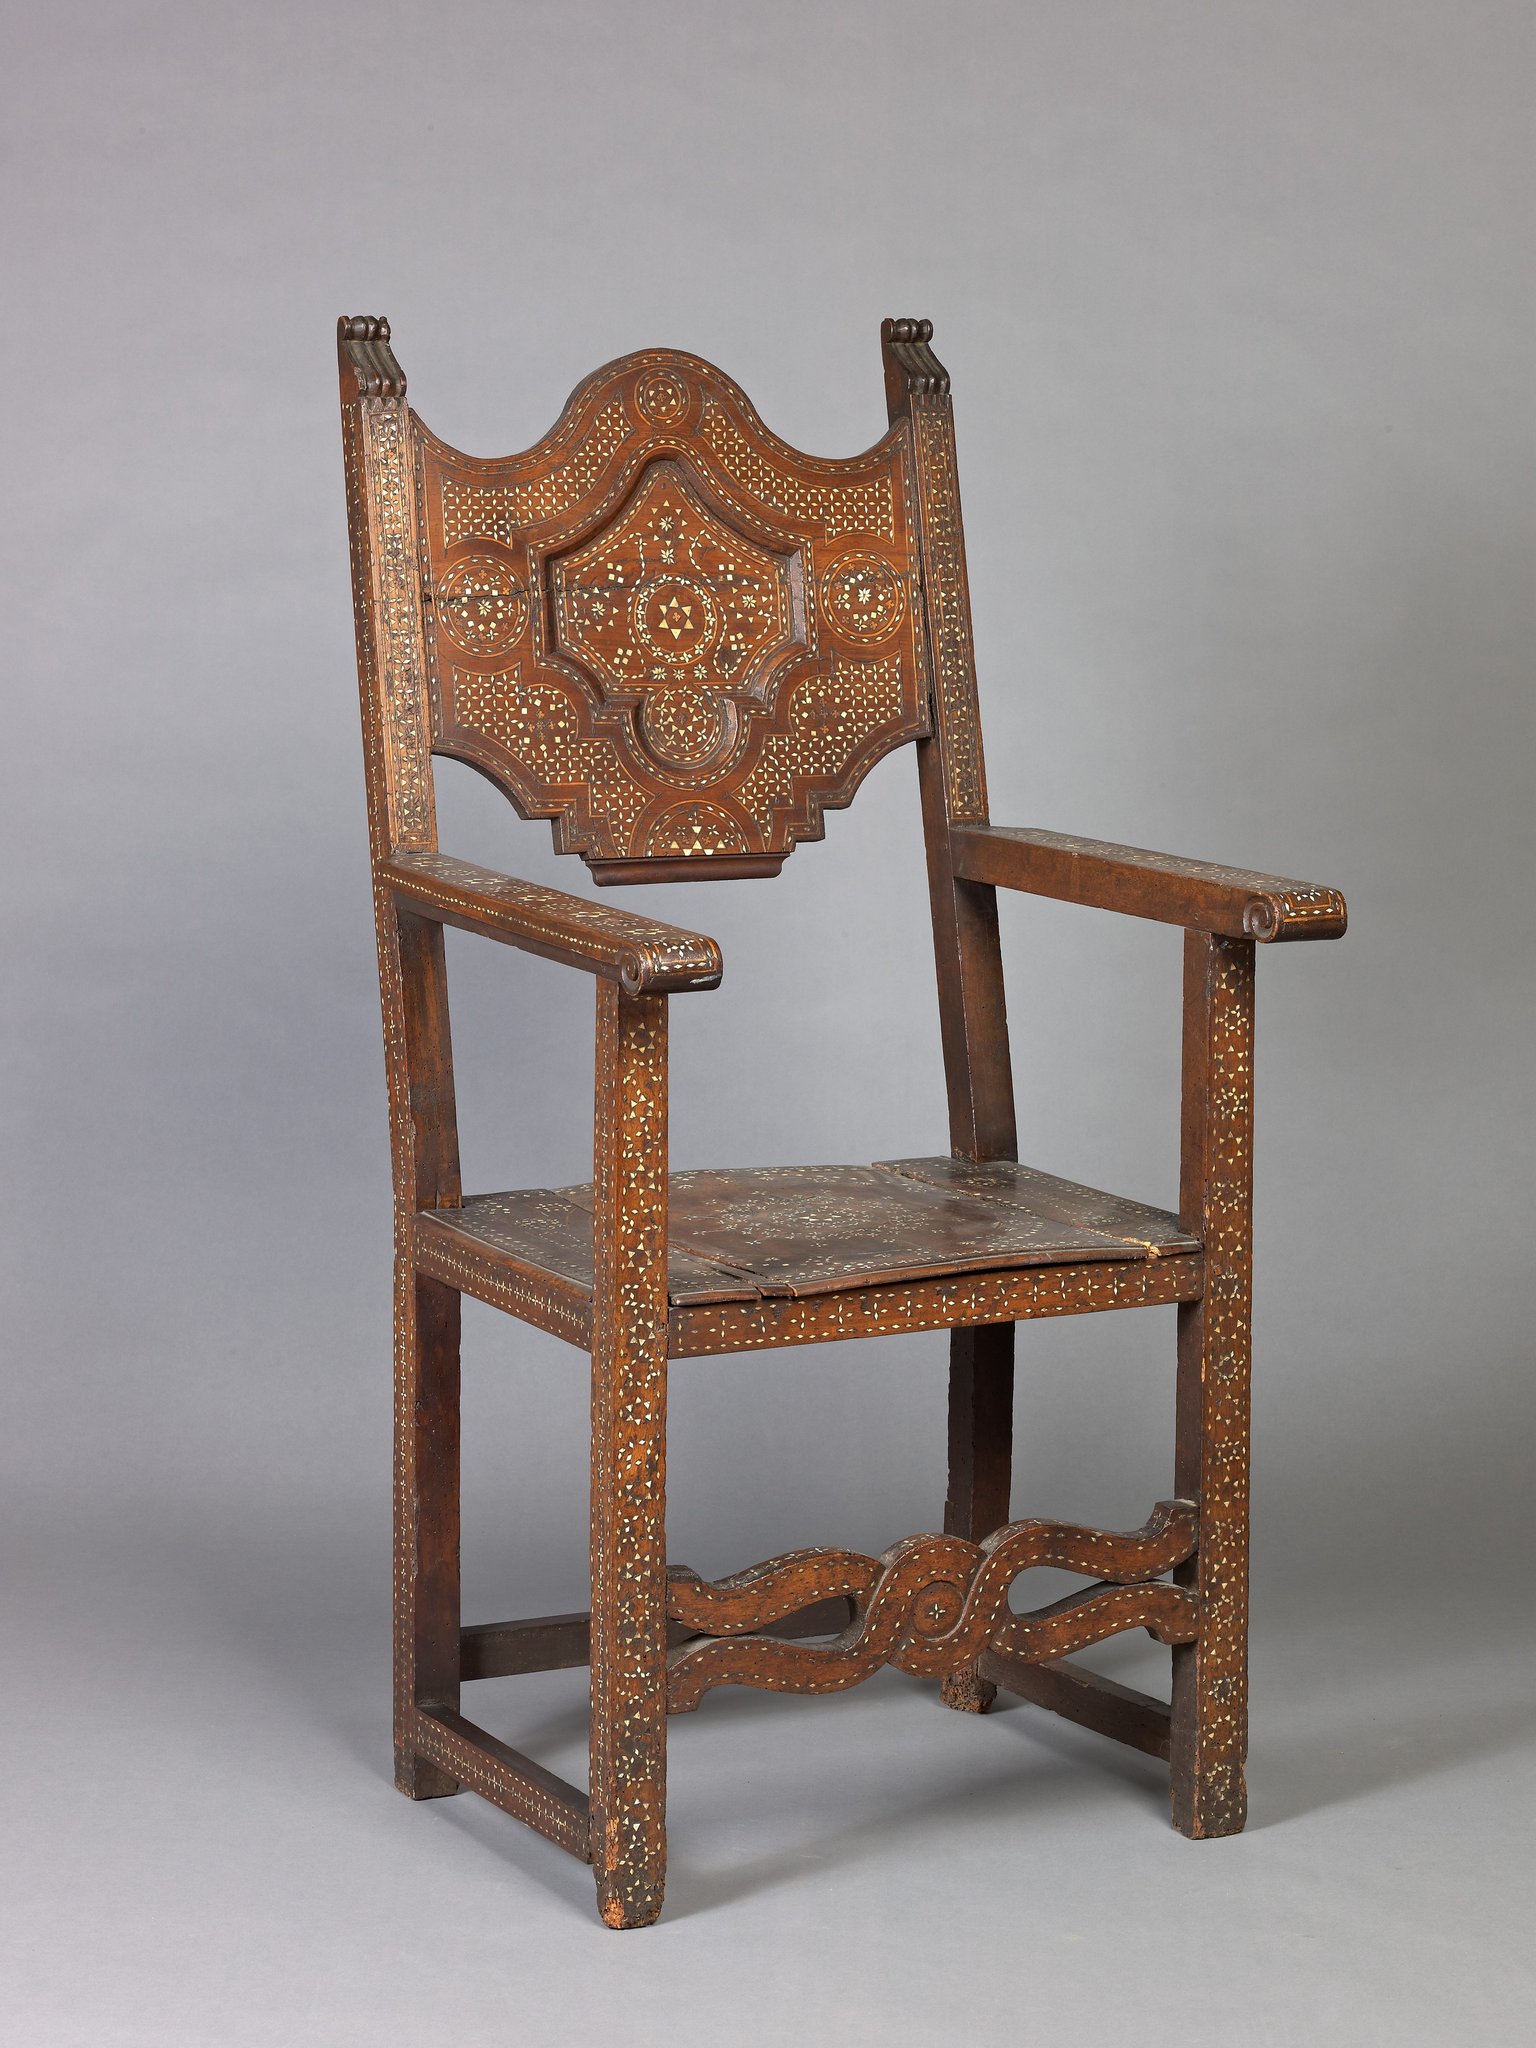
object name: chair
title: High-back chair (pair with 1975.1.1998)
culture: north african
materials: bone, ivory